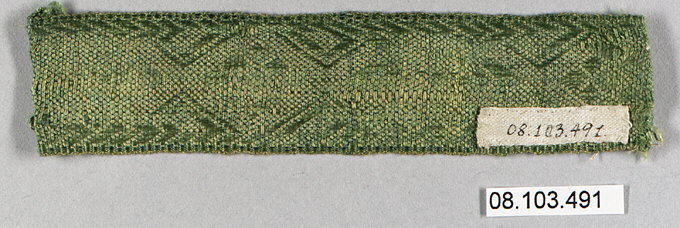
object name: galloon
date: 1701-1800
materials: cotton, silk